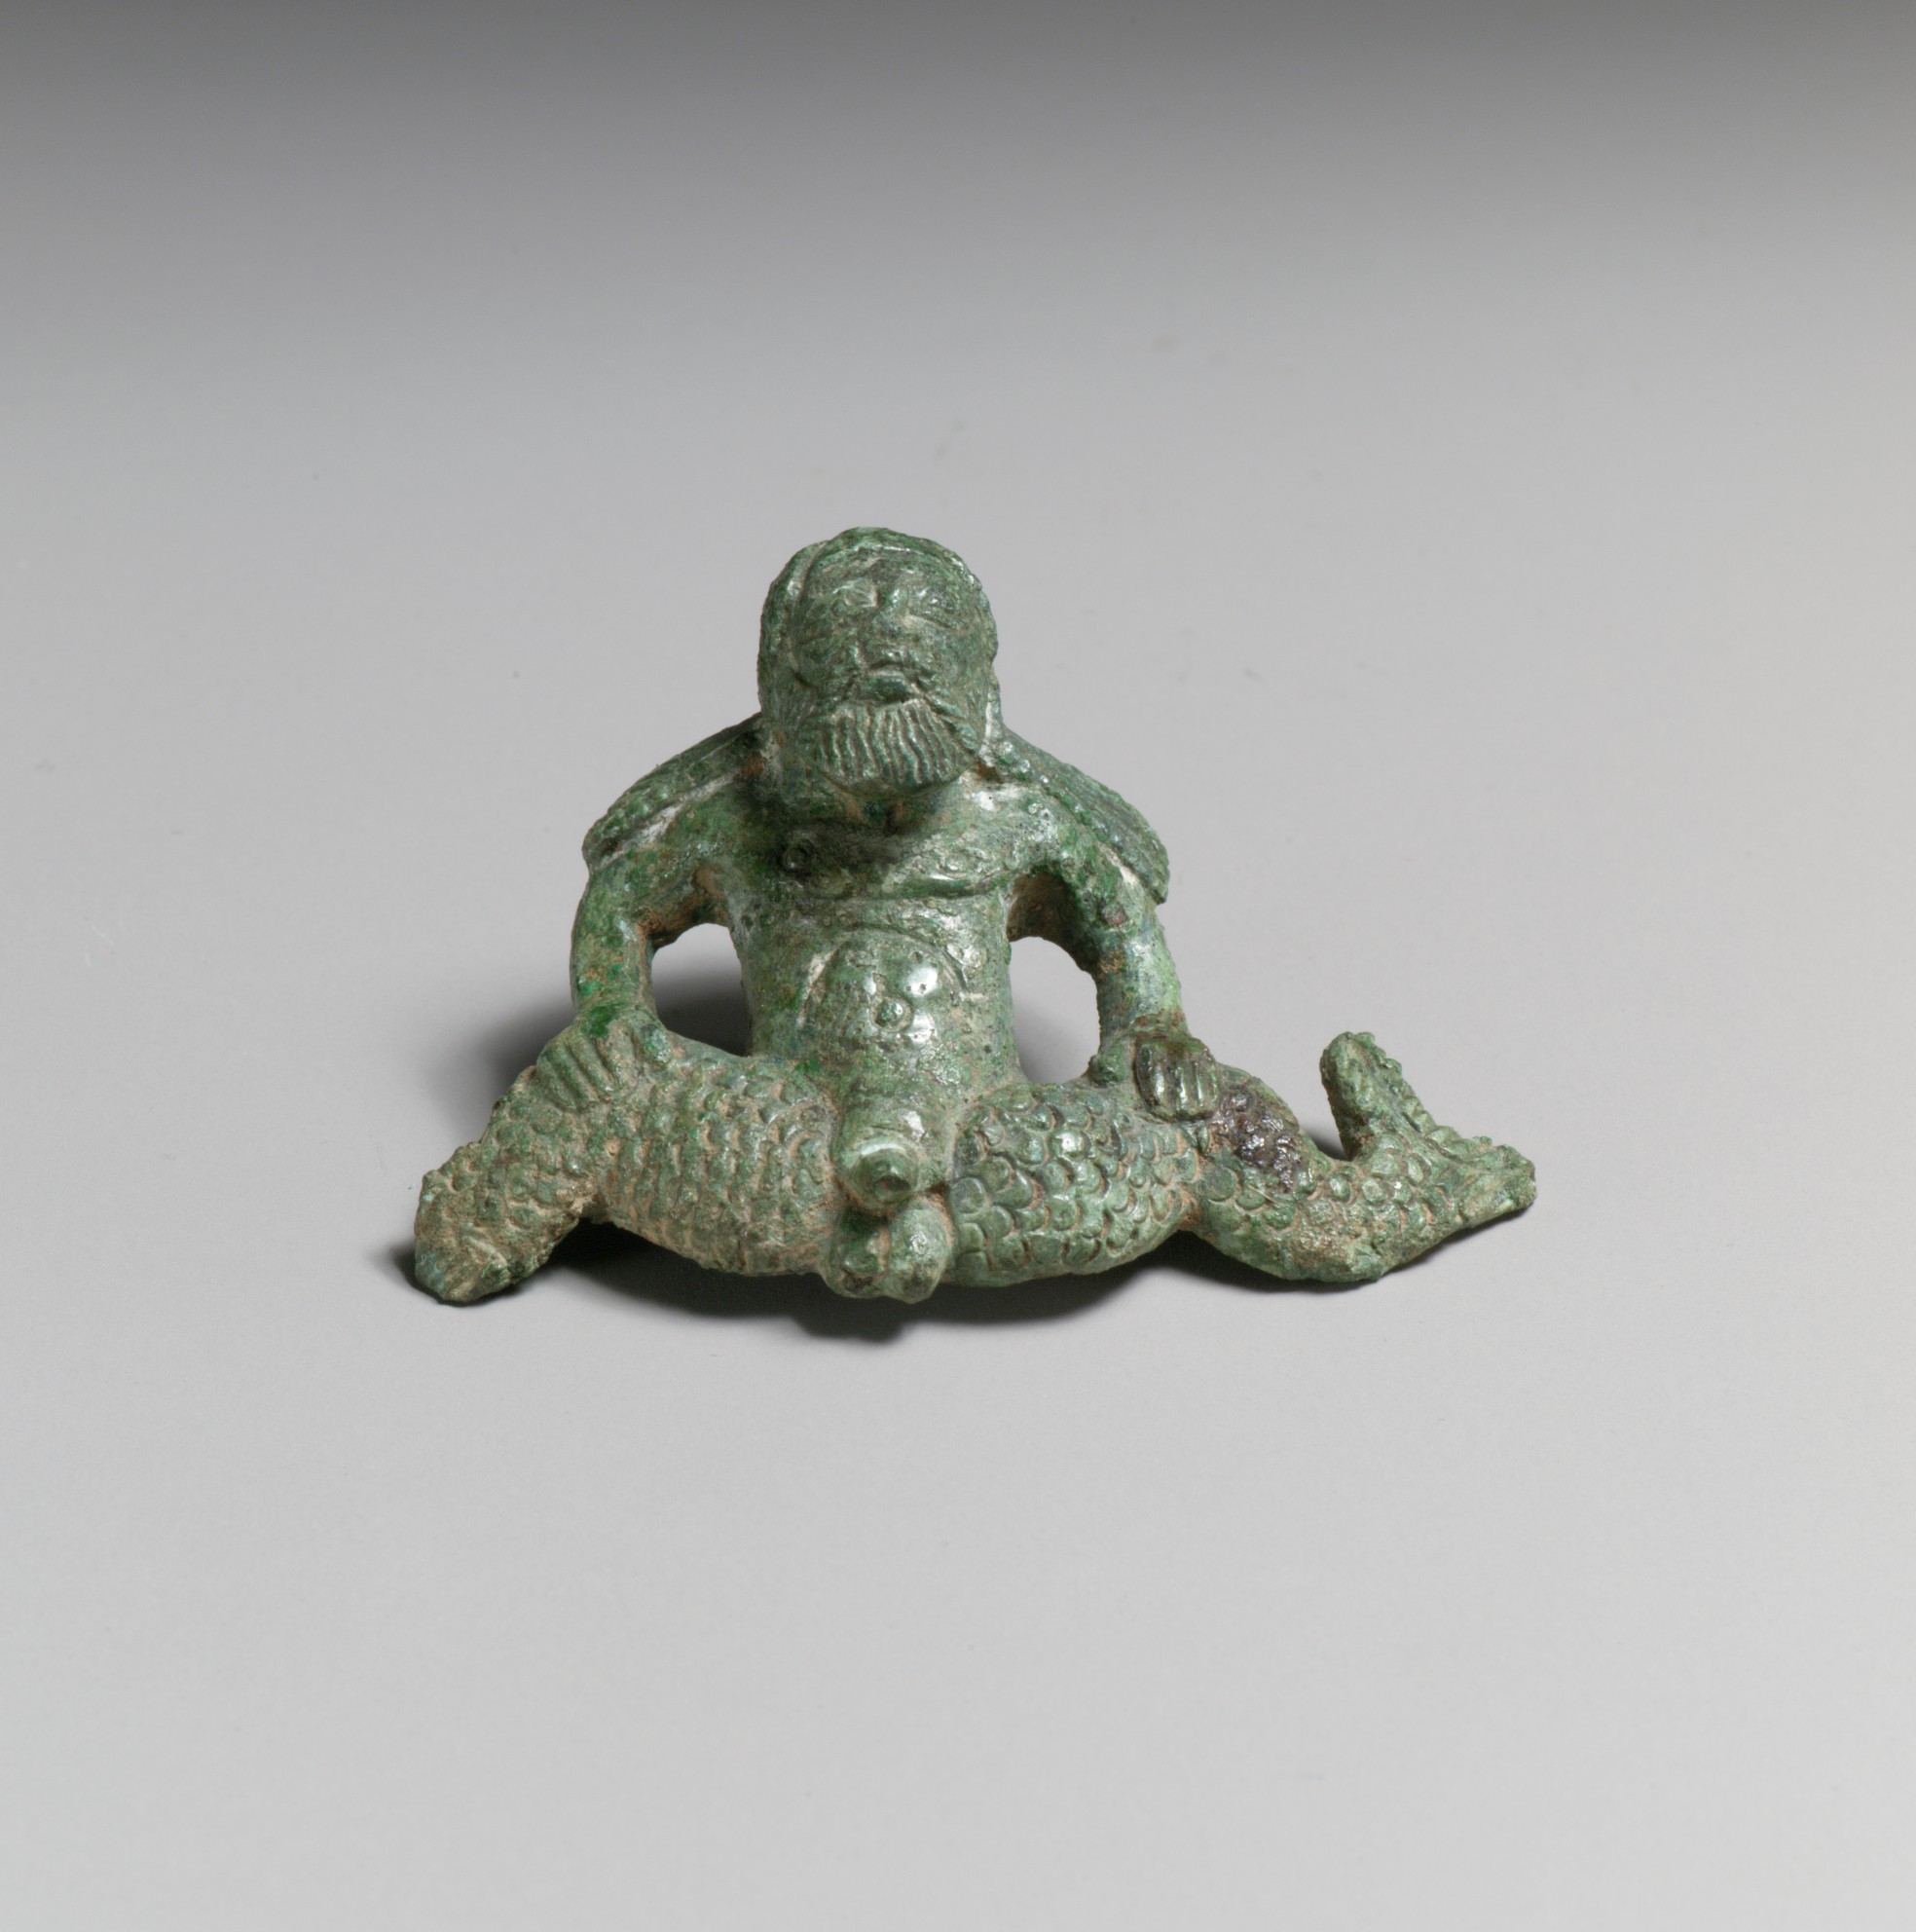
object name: helmet attachment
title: Bronze helmet attachment in the shape of a triton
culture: etruscan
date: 600-501 BCE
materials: bronze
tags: helmets,triton